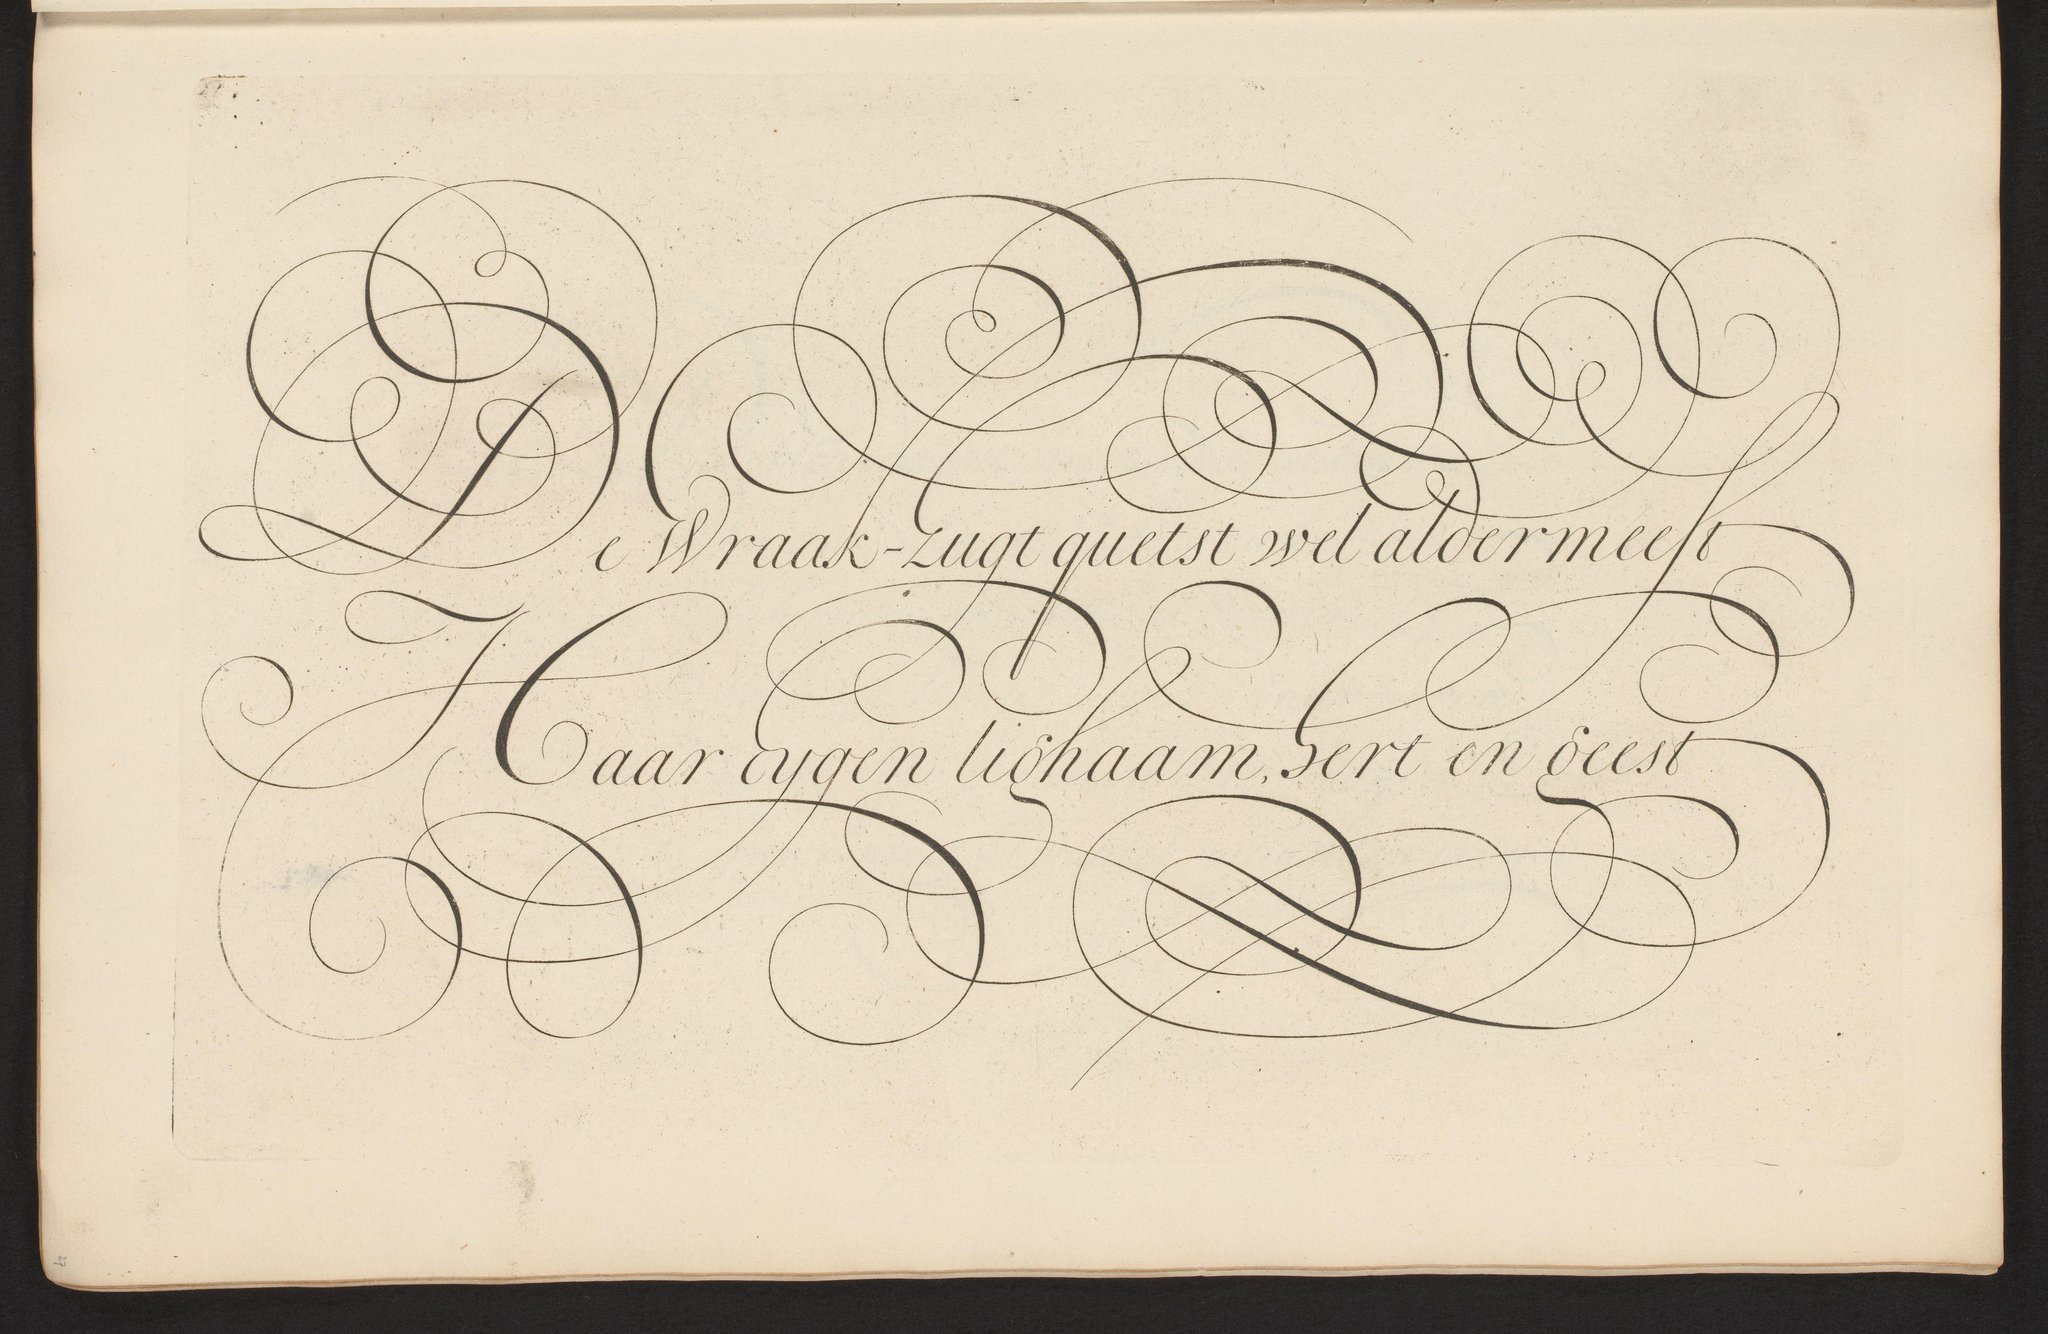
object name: album leaf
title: Schrijfvoorbeeld: De Wraak-zugt quetst wel aldermeest (...)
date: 1660-1751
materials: paper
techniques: engraving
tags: calligraphy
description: Schrijfvoorbeeld met twee regels tekst in het Frans: De Wraak-zugt quetst wel aldermeest ... De prent maakt deel uit van een album